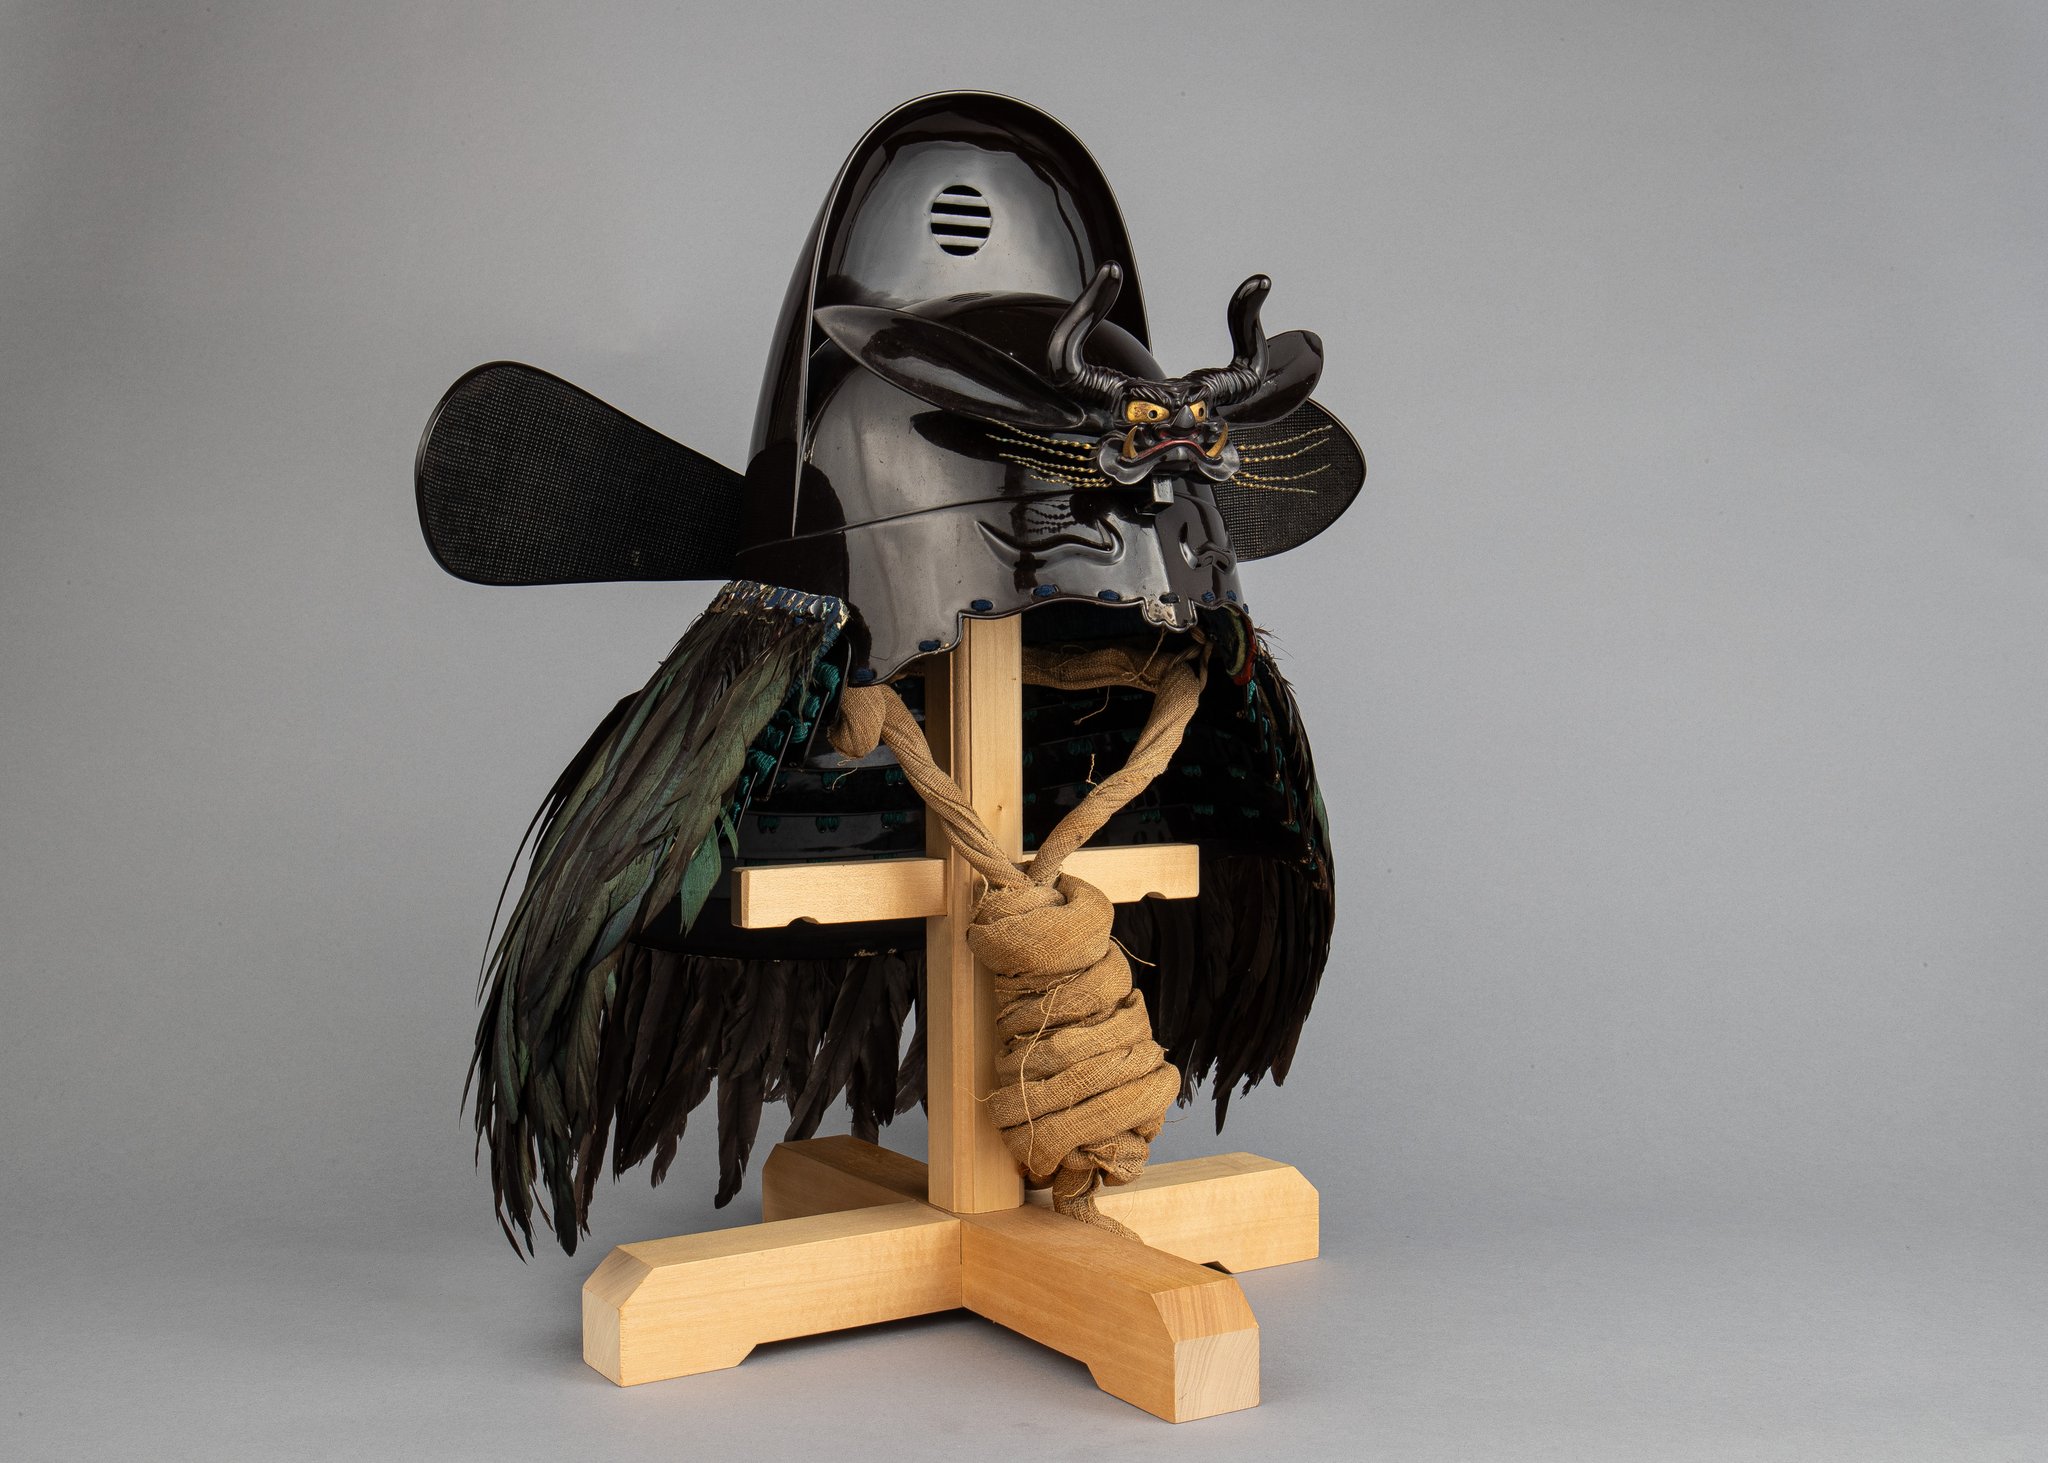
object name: helmet with rain protector, right and left crown crest, and demon faced crest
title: Helmet with Rain Protector and Crests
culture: japanese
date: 1801-1900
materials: brass, feather, gold, iron, lacquer, leather, silver, textile, wood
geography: japan